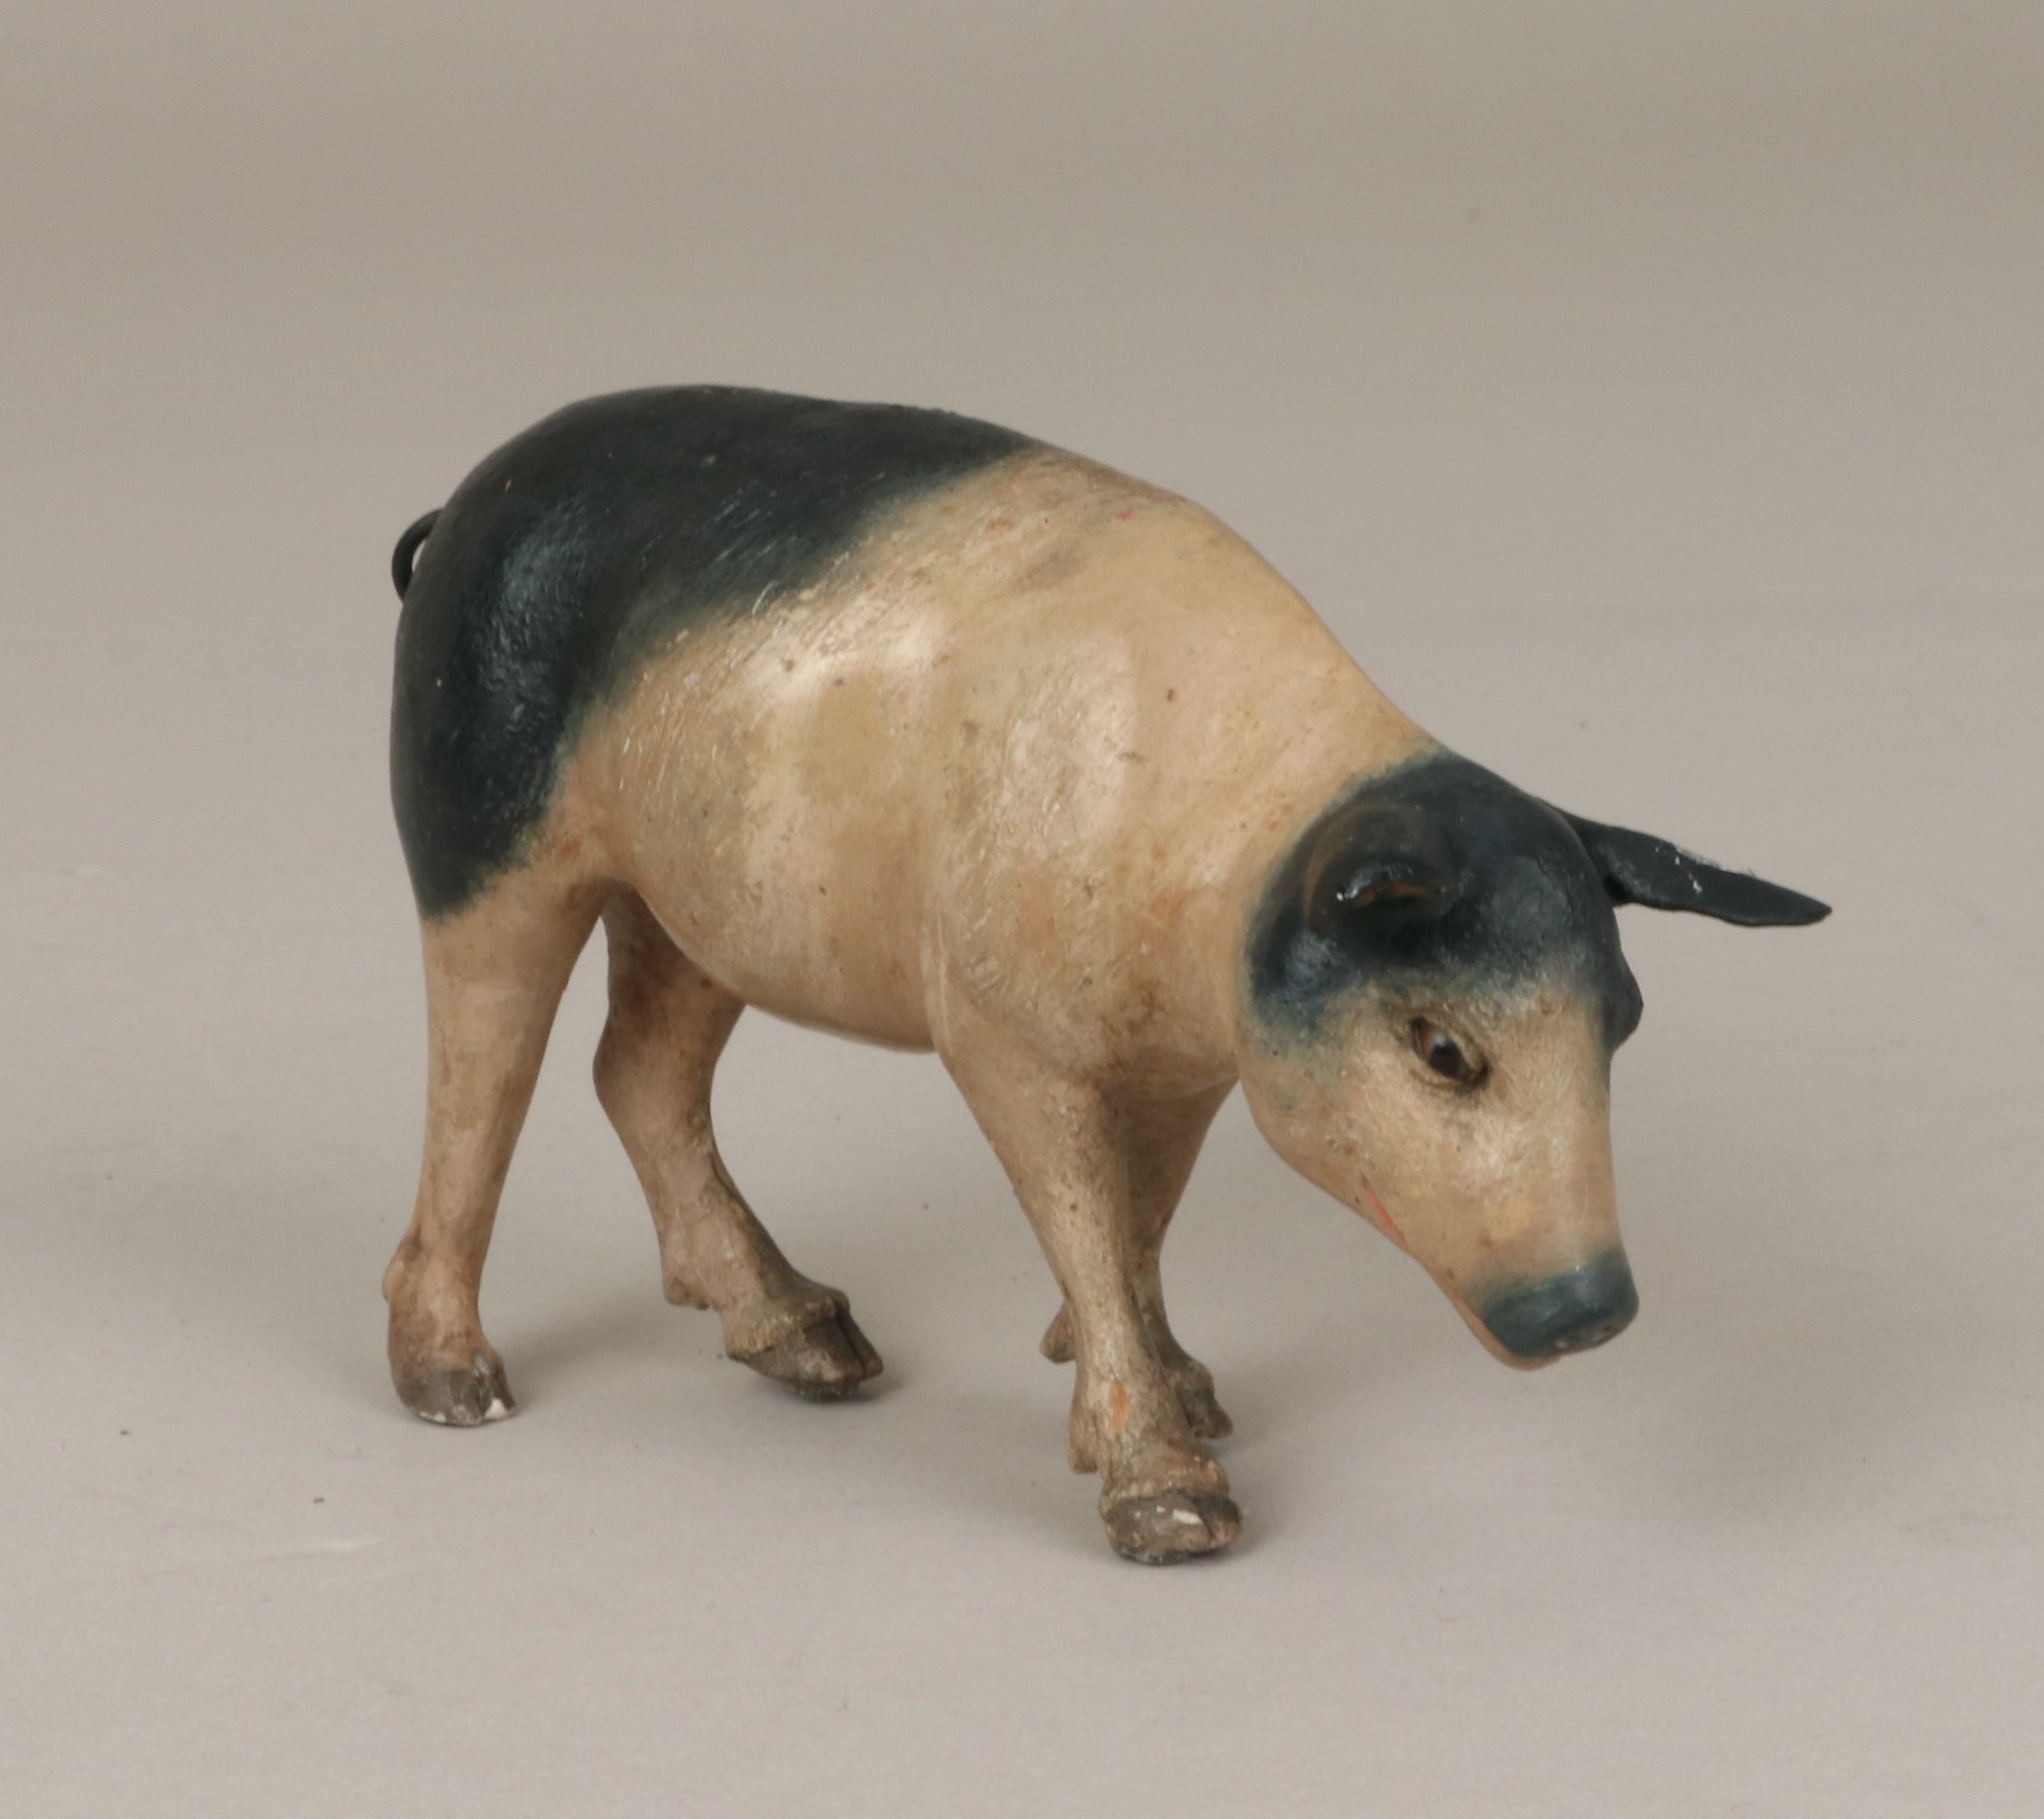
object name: crèche figure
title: Pig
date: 1701-1800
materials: terracotta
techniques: polychrome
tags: pigs